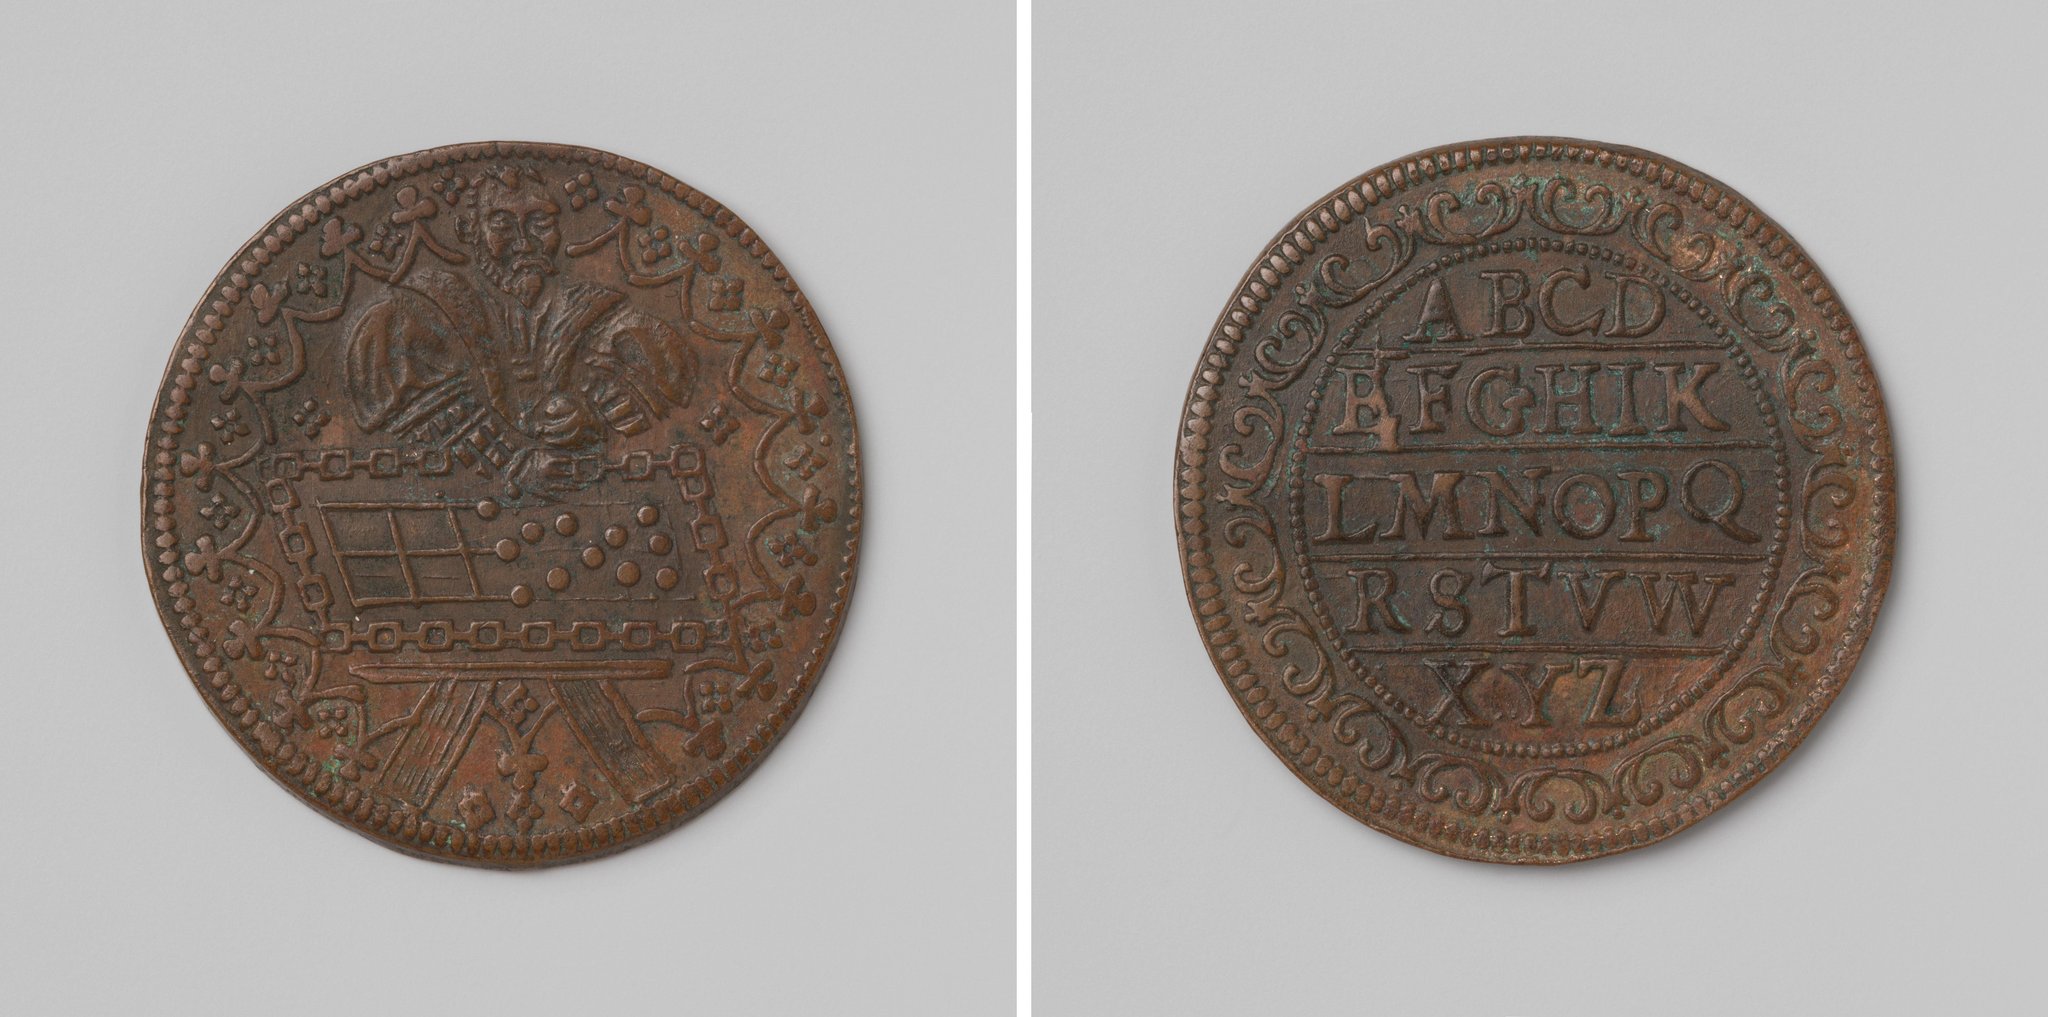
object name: jeton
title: Schoolpenning: rekenpenning waarop het werken met rekenpenningen en het alfabet worden getoond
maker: Anonymous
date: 1525-1575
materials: copper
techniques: striking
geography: netherlands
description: Koperen penning. Voorzijde: man staande achter tafel, waarop lijnen zijn getrokken en penningen liggen binnen sierrand. Keerzijde: alfabet in vijf boven elkaar geplaatste regels binnen sierrand.